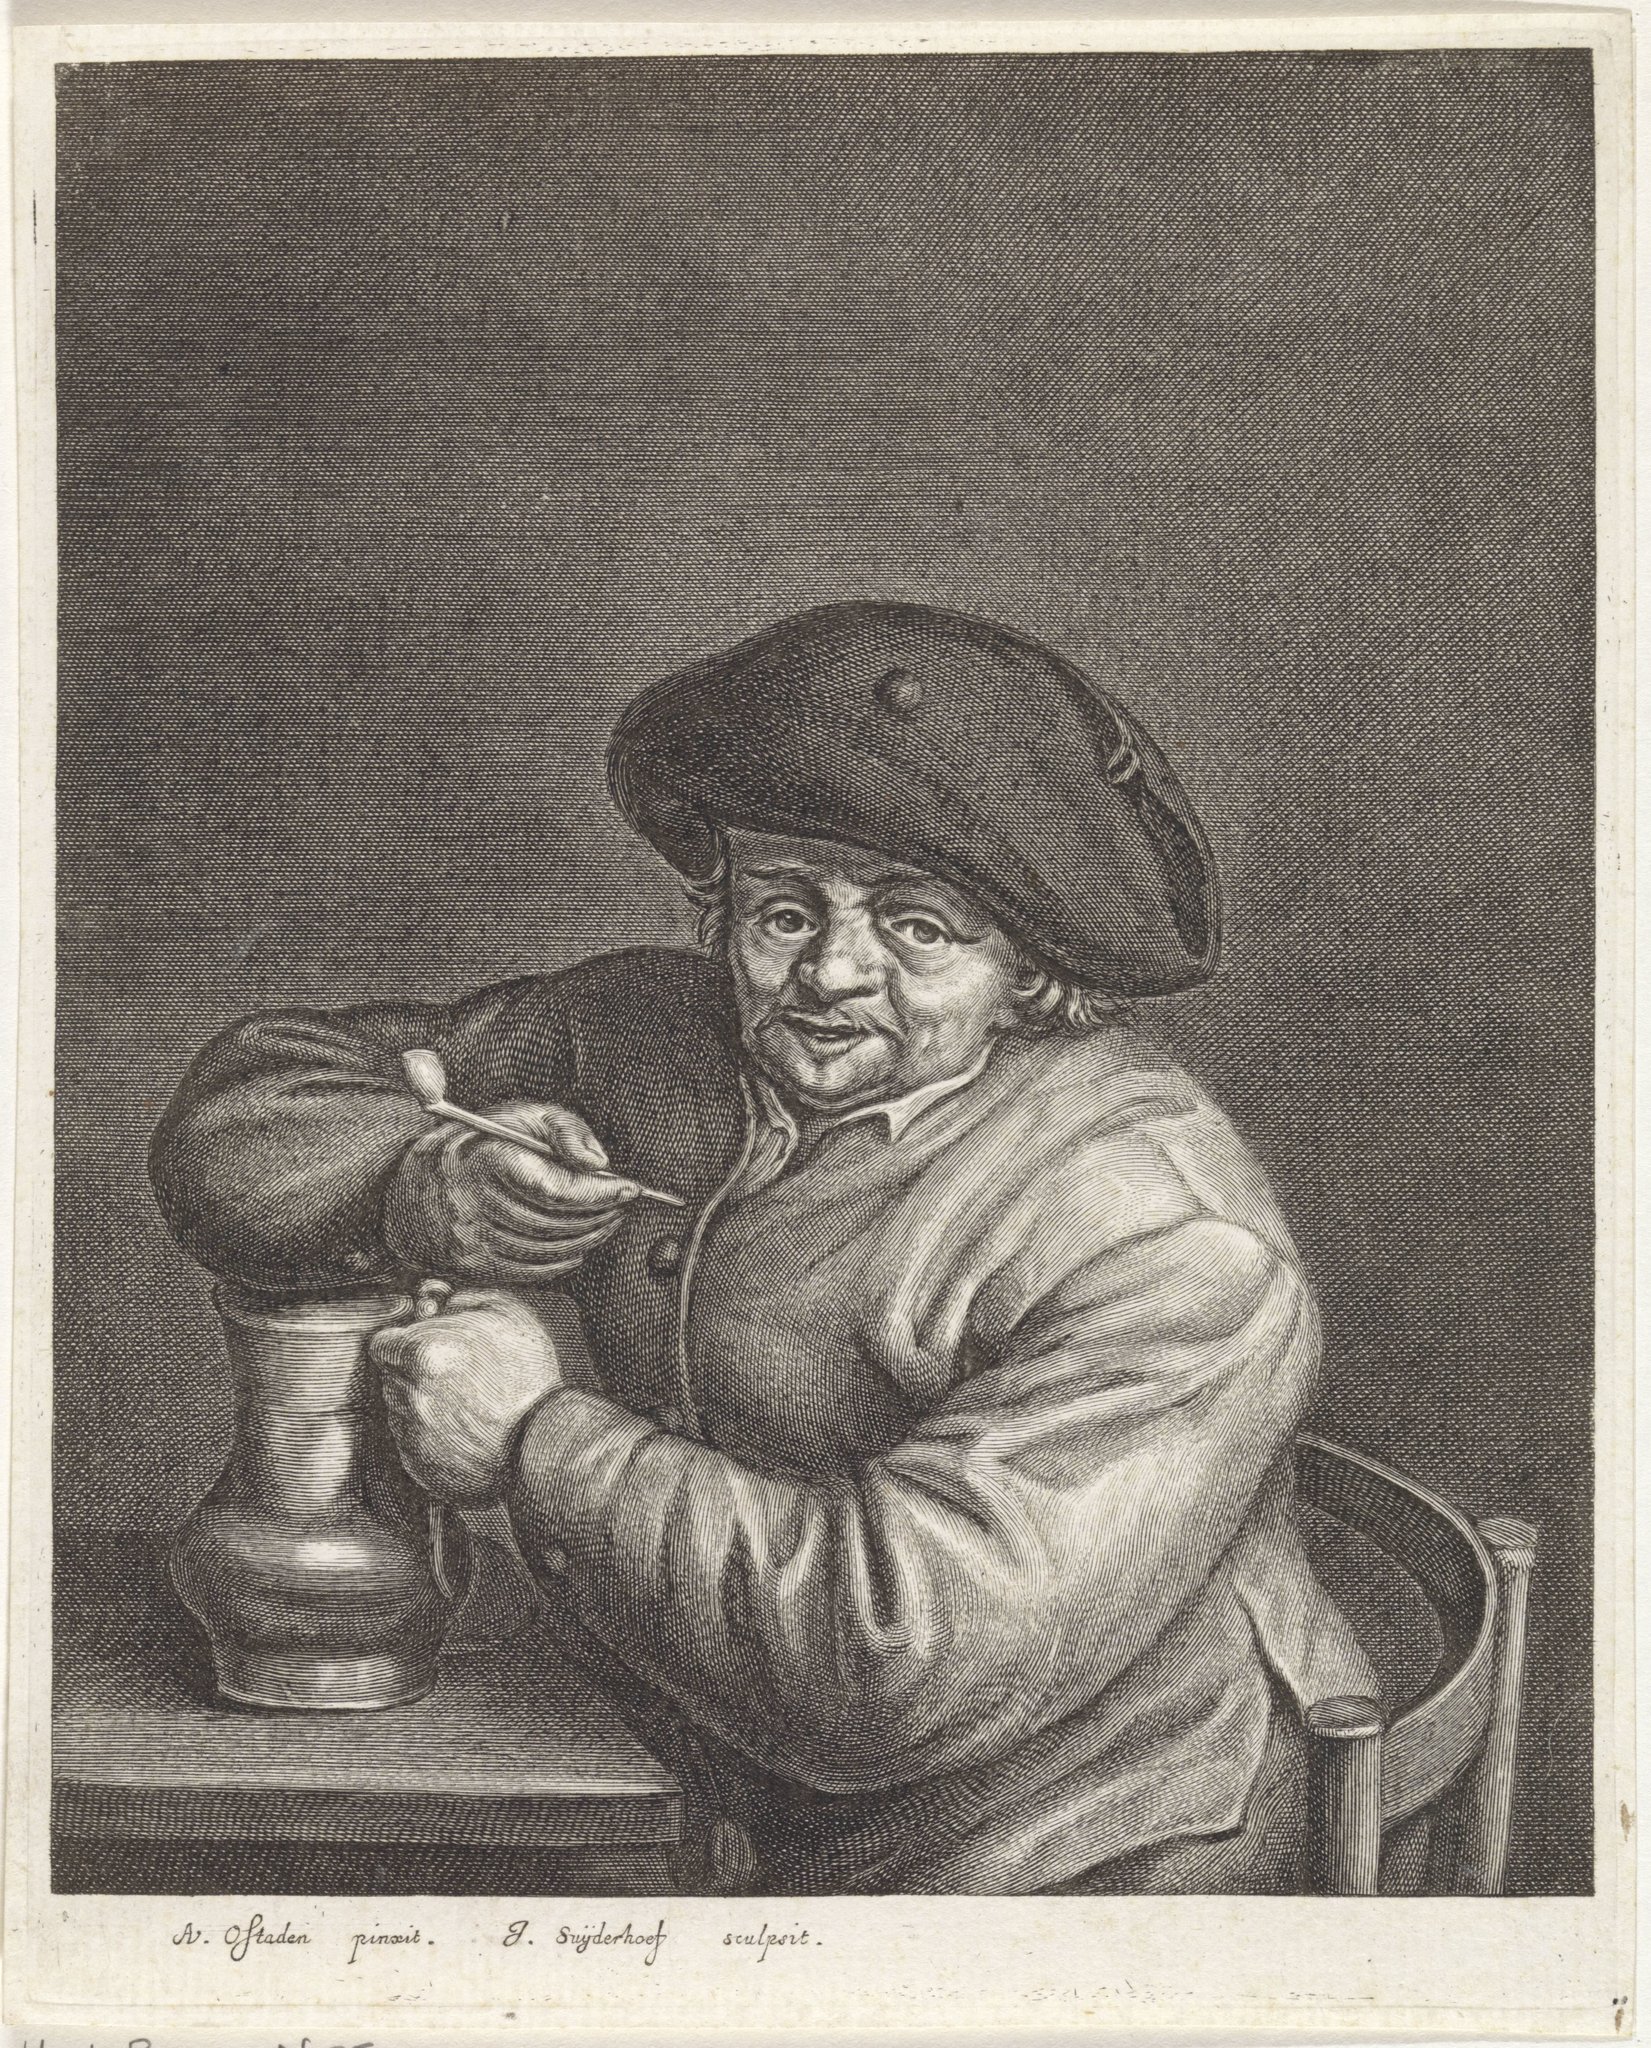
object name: print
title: Boer met pijp en kruik in de hand bij een tafel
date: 1623-1686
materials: paper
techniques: engraving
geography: haarlem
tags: pipe ~ tobacco, jar, jug (used as drinking-vessel)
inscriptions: collector's mark: Lugt 10, collector's mark: Lugt 11, collector's mark: ‘Hinloopen’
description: Een boer zit een tafel met een pijp en kruik in de handen.